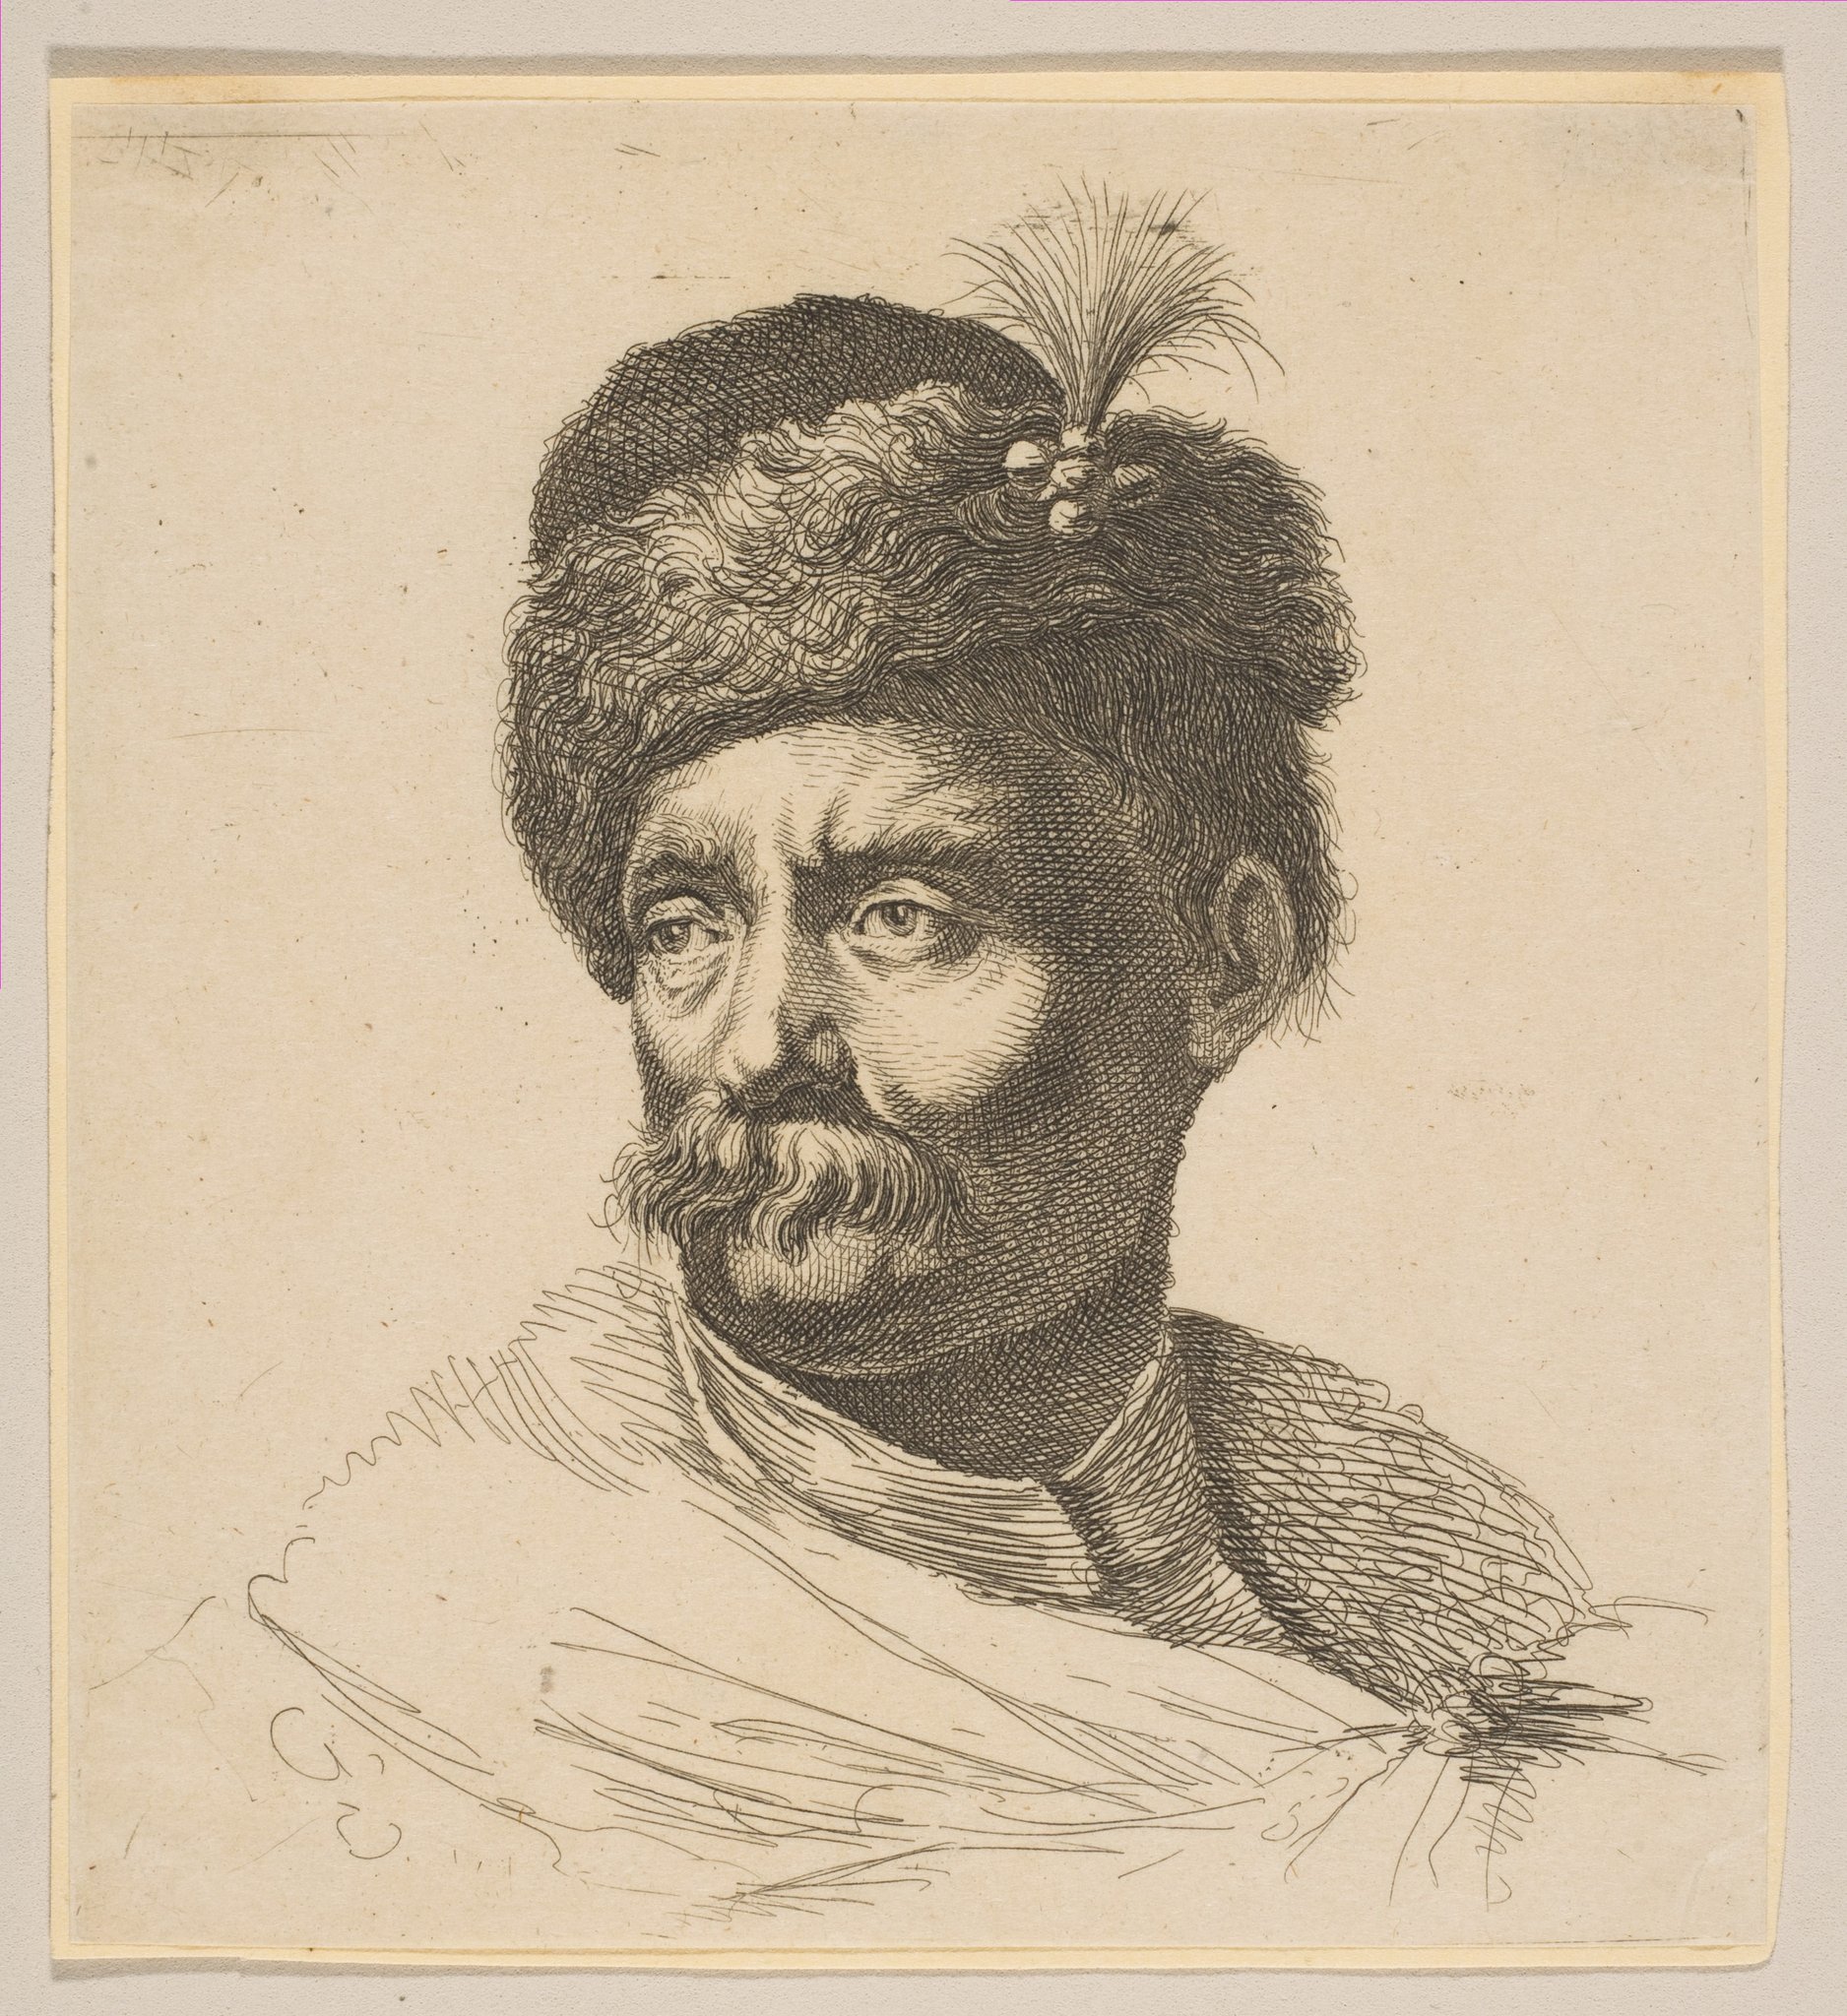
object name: print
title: Bust of a Pole, from "Drawing Basics" (I principii del disegno)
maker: stefano della bella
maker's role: artist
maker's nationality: italian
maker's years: 1610-1664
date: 1641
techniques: etching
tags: men,portraits